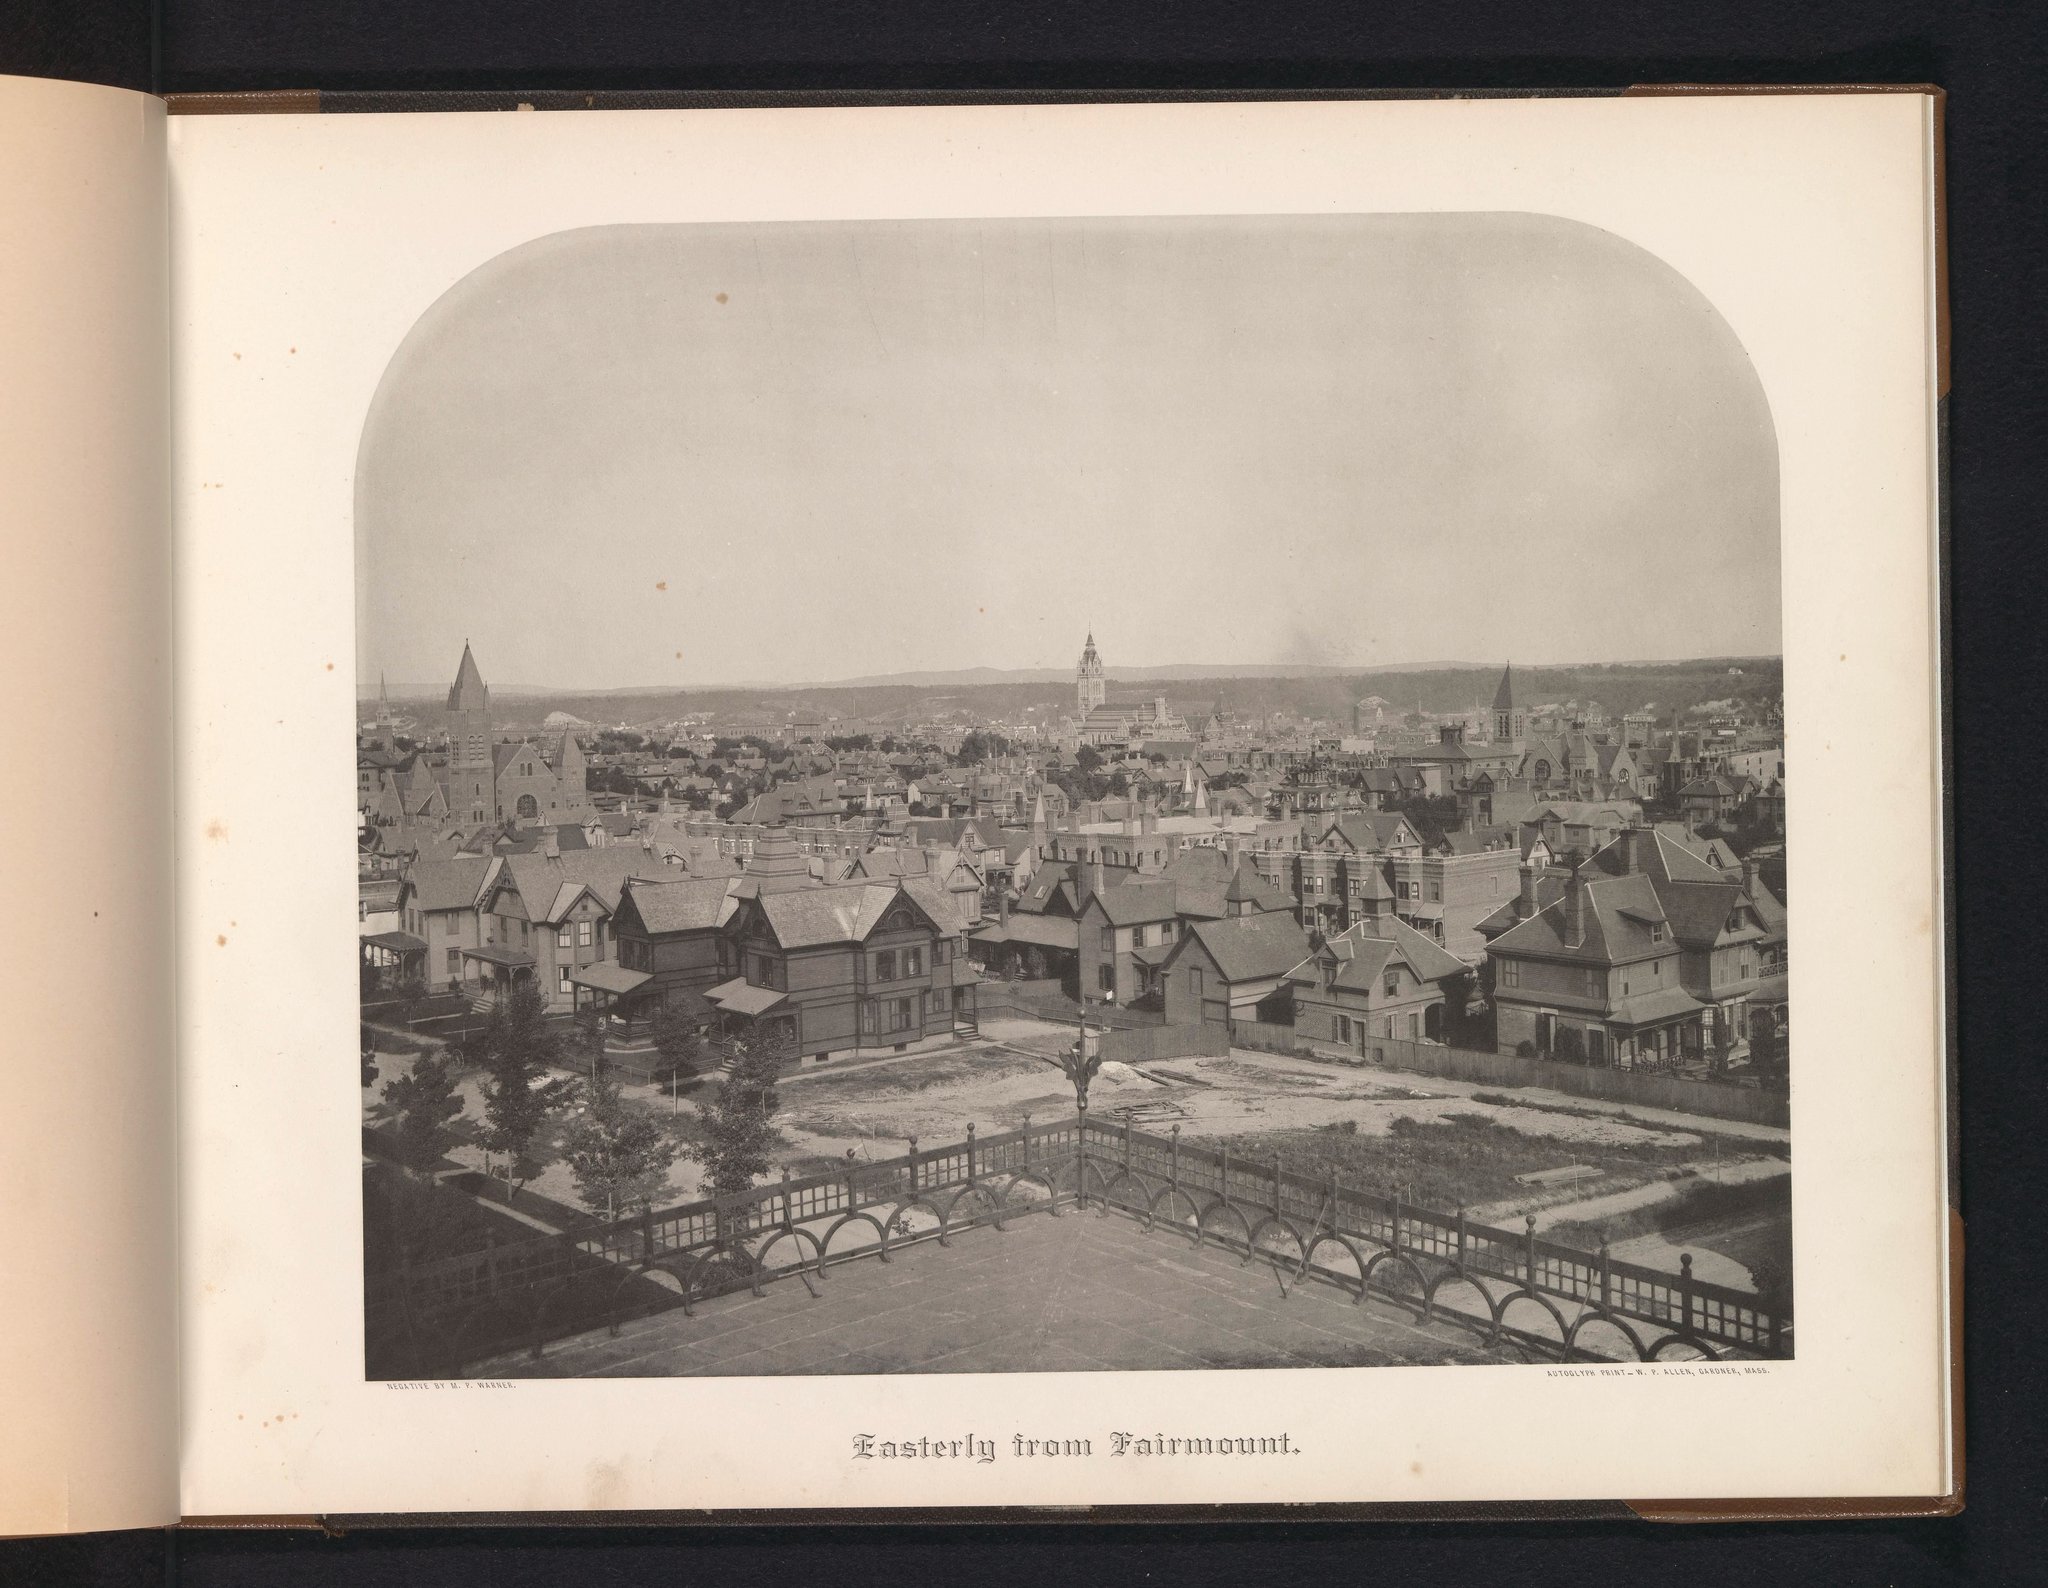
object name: photomechanical print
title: Easterly from Fairmount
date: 1883-1888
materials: paper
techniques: photograph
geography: massachusetts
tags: city-view in general; 'veduta'